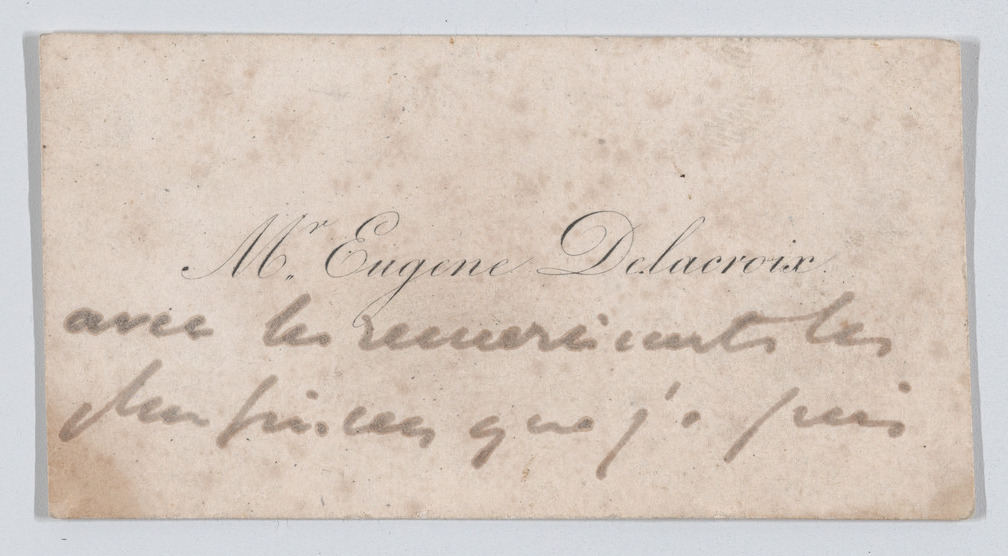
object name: print, calling card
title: Eugène Delacroix, calling card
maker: Anonymous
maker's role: artist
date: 1822-1863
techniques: engraving